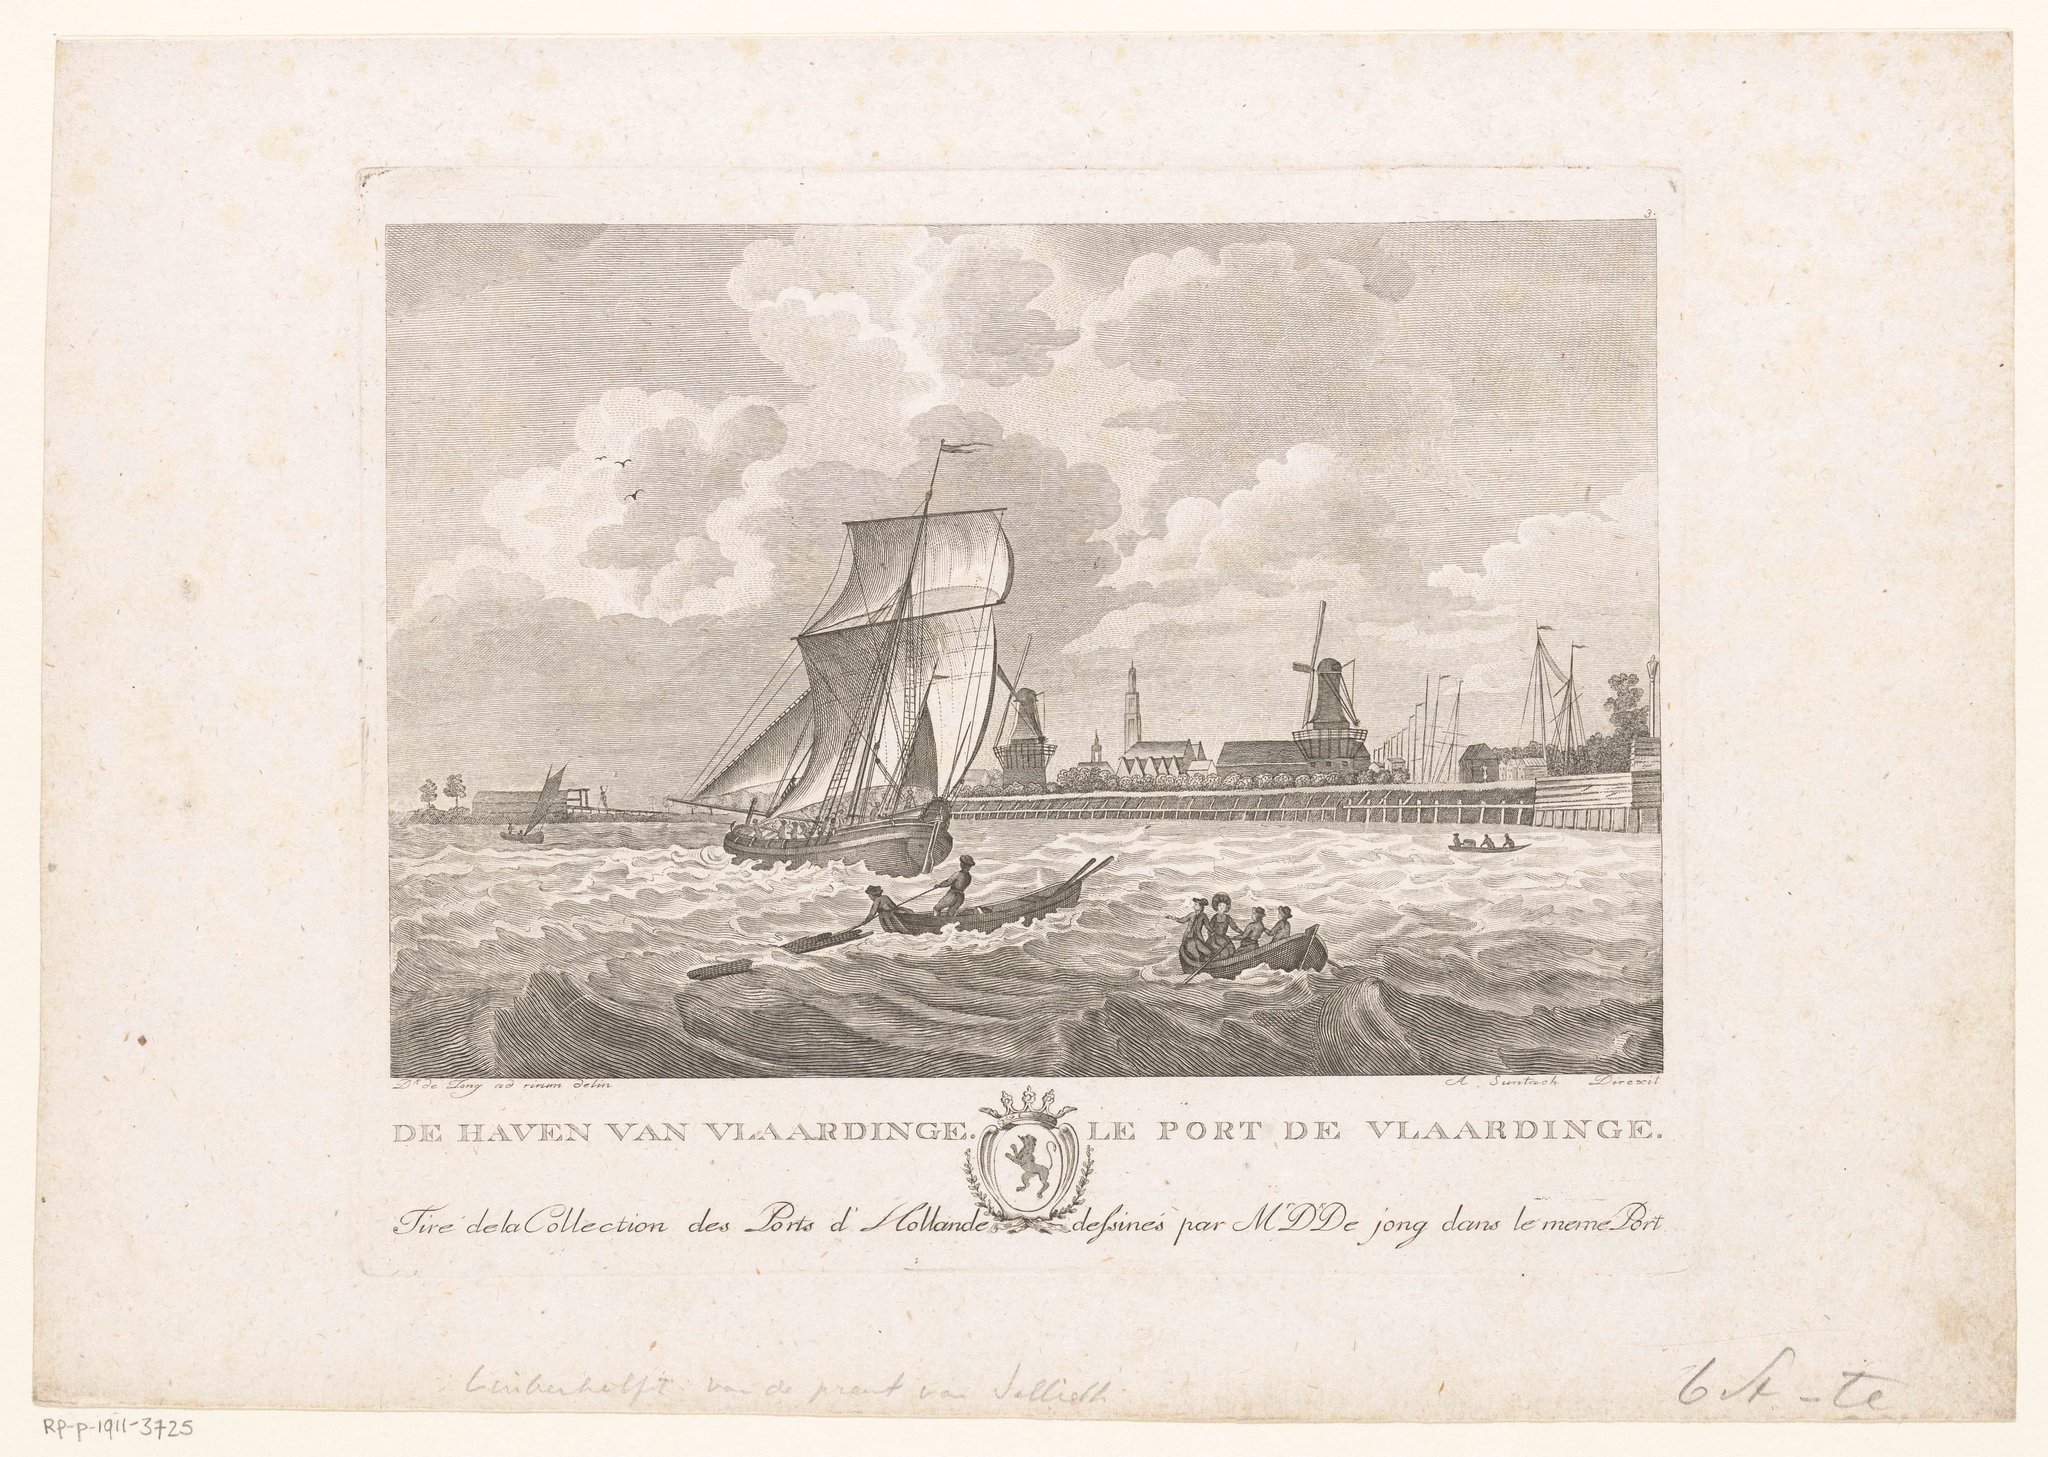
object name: print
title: Havens van Holland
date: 1754-1828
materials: paper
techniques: engraving, etching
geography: vlaardingen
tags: harbour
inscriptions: collector's mark: Lugt 2228